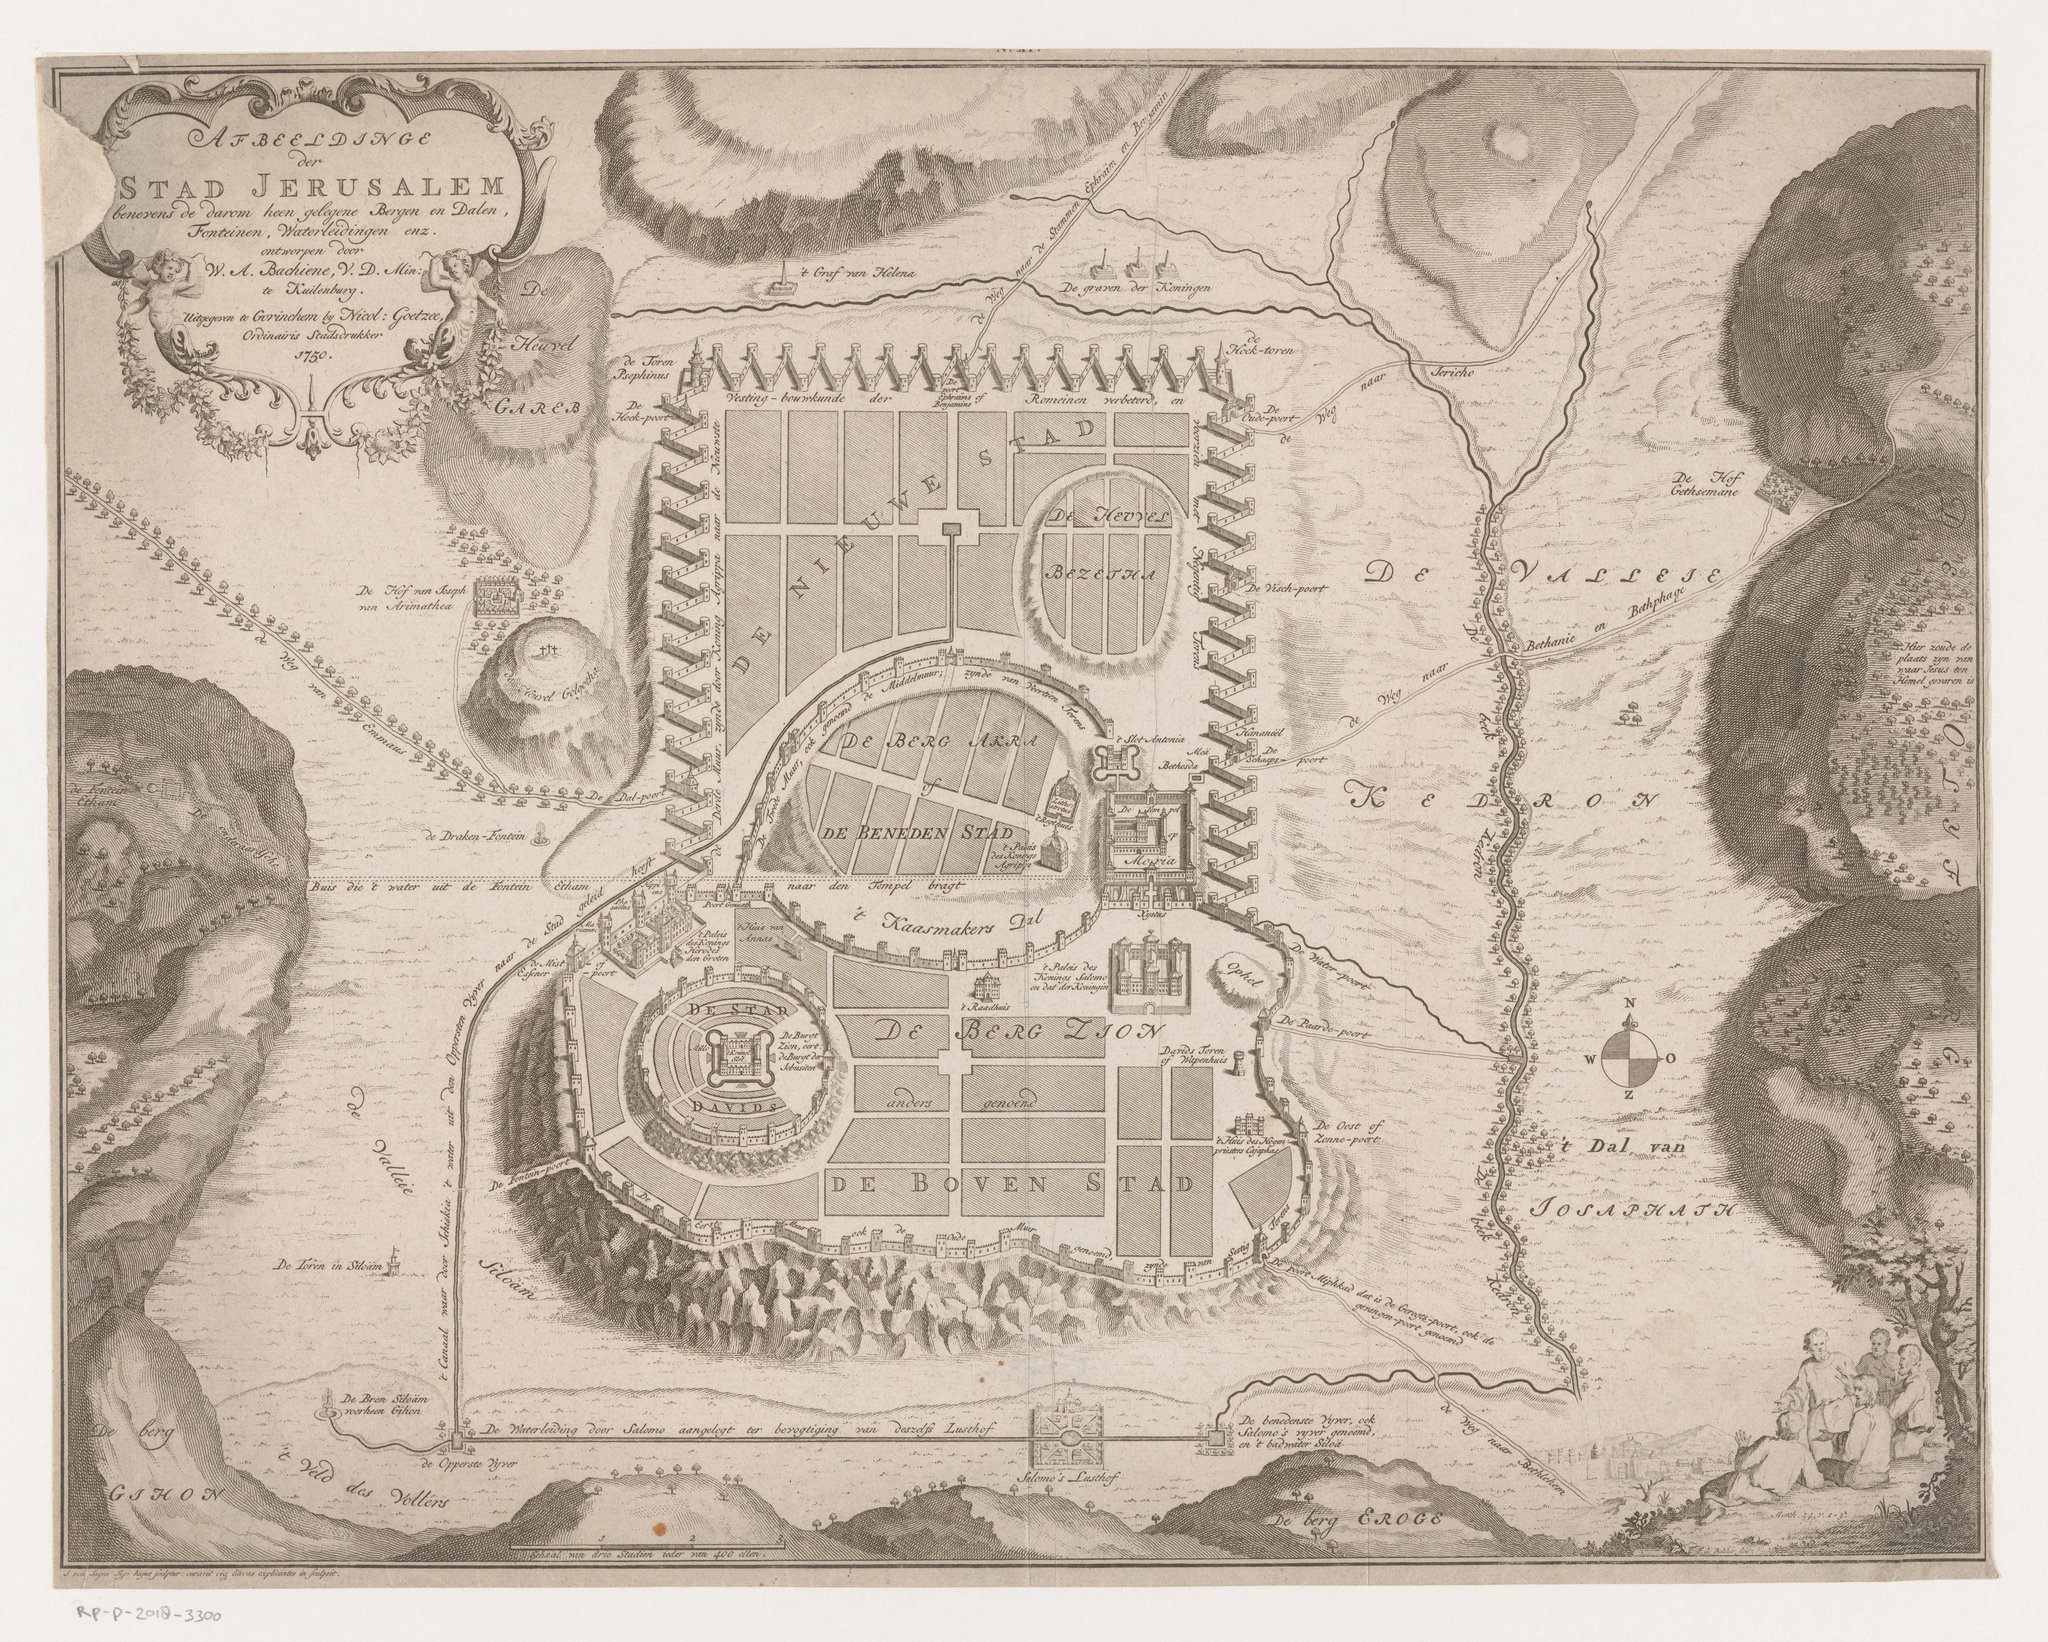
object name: print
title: Plattegrond van Jeruzalem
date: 1750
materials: paper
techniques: etching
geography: culemborg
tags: maps of cities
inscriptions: collector's mark: Lugt 2228